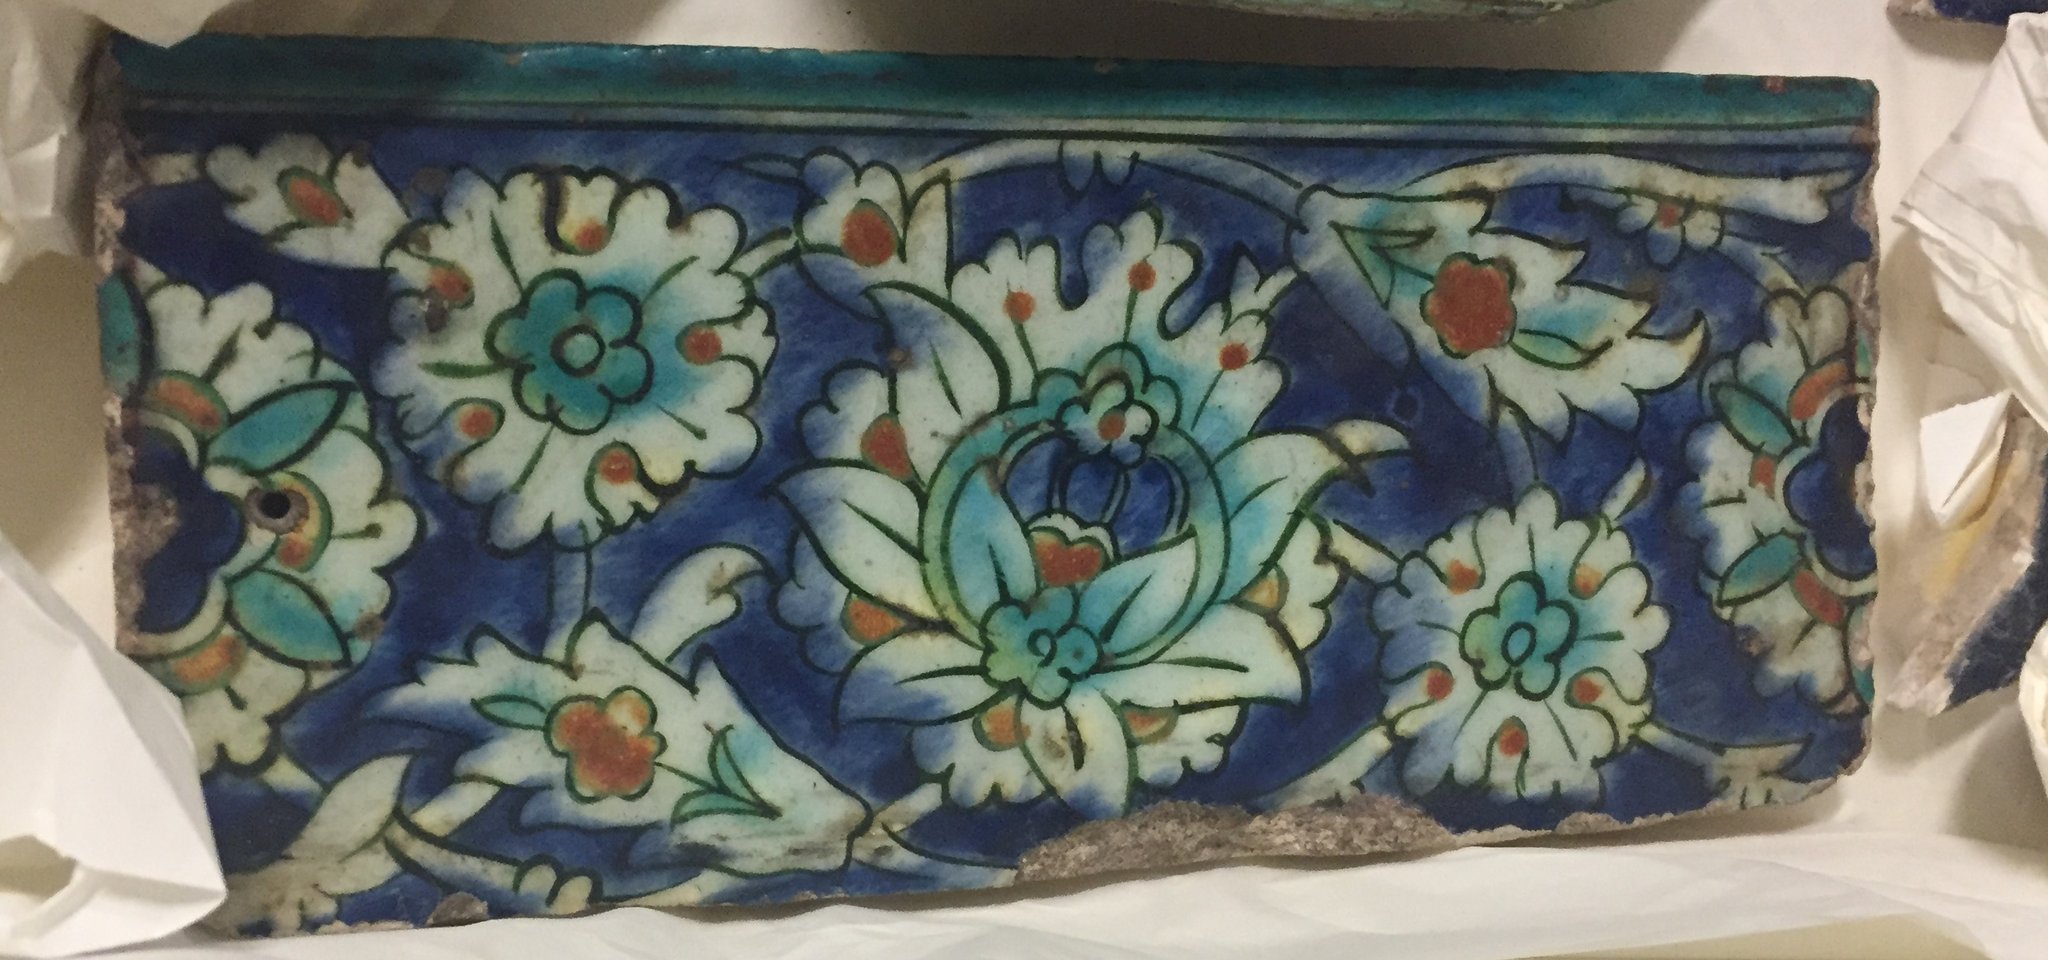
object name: tile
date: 1601-1650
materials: stonepaste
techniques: painting, underglaze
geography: turkey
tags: flowers